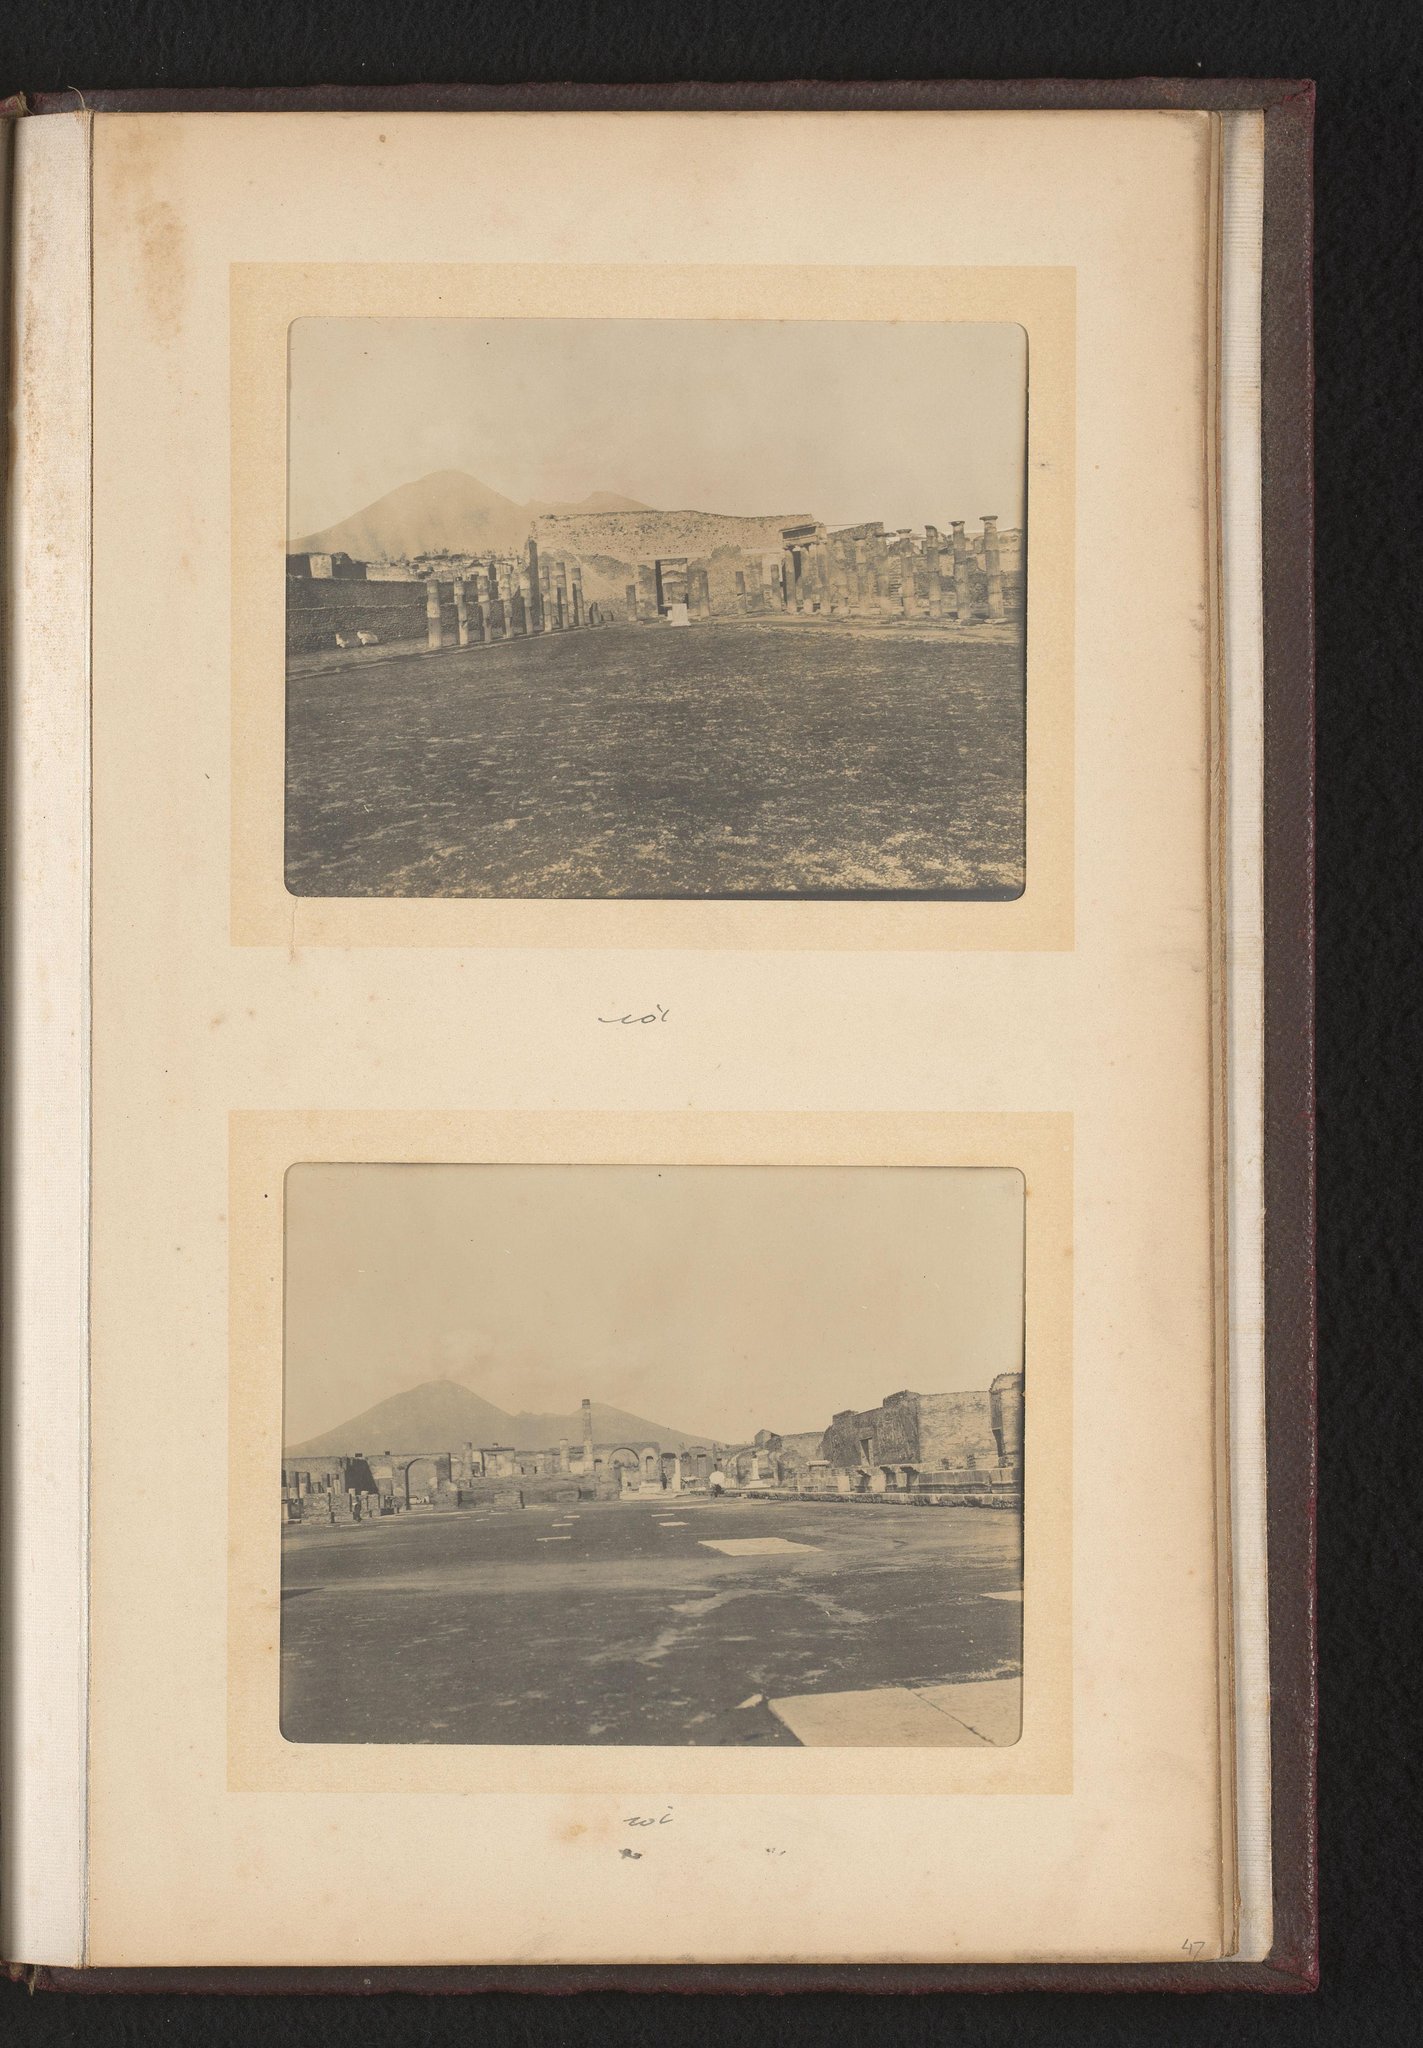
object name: photograph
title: Twee gezichten te Pompeï met de Vesuvius op de achtergrond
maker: Anonymous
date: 1895-1905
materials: cardboard, photographic support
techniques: gelatin silver print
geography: pompeii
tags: tourism, landscape with ruins, volcano, mount vesuvius, pompeii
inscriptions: inscription: ‘id. / id.’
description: Albumblad met twee foto's in Pompeï. Onderdeel van een fotoalbum van een reis door Italië, ca. 1900.